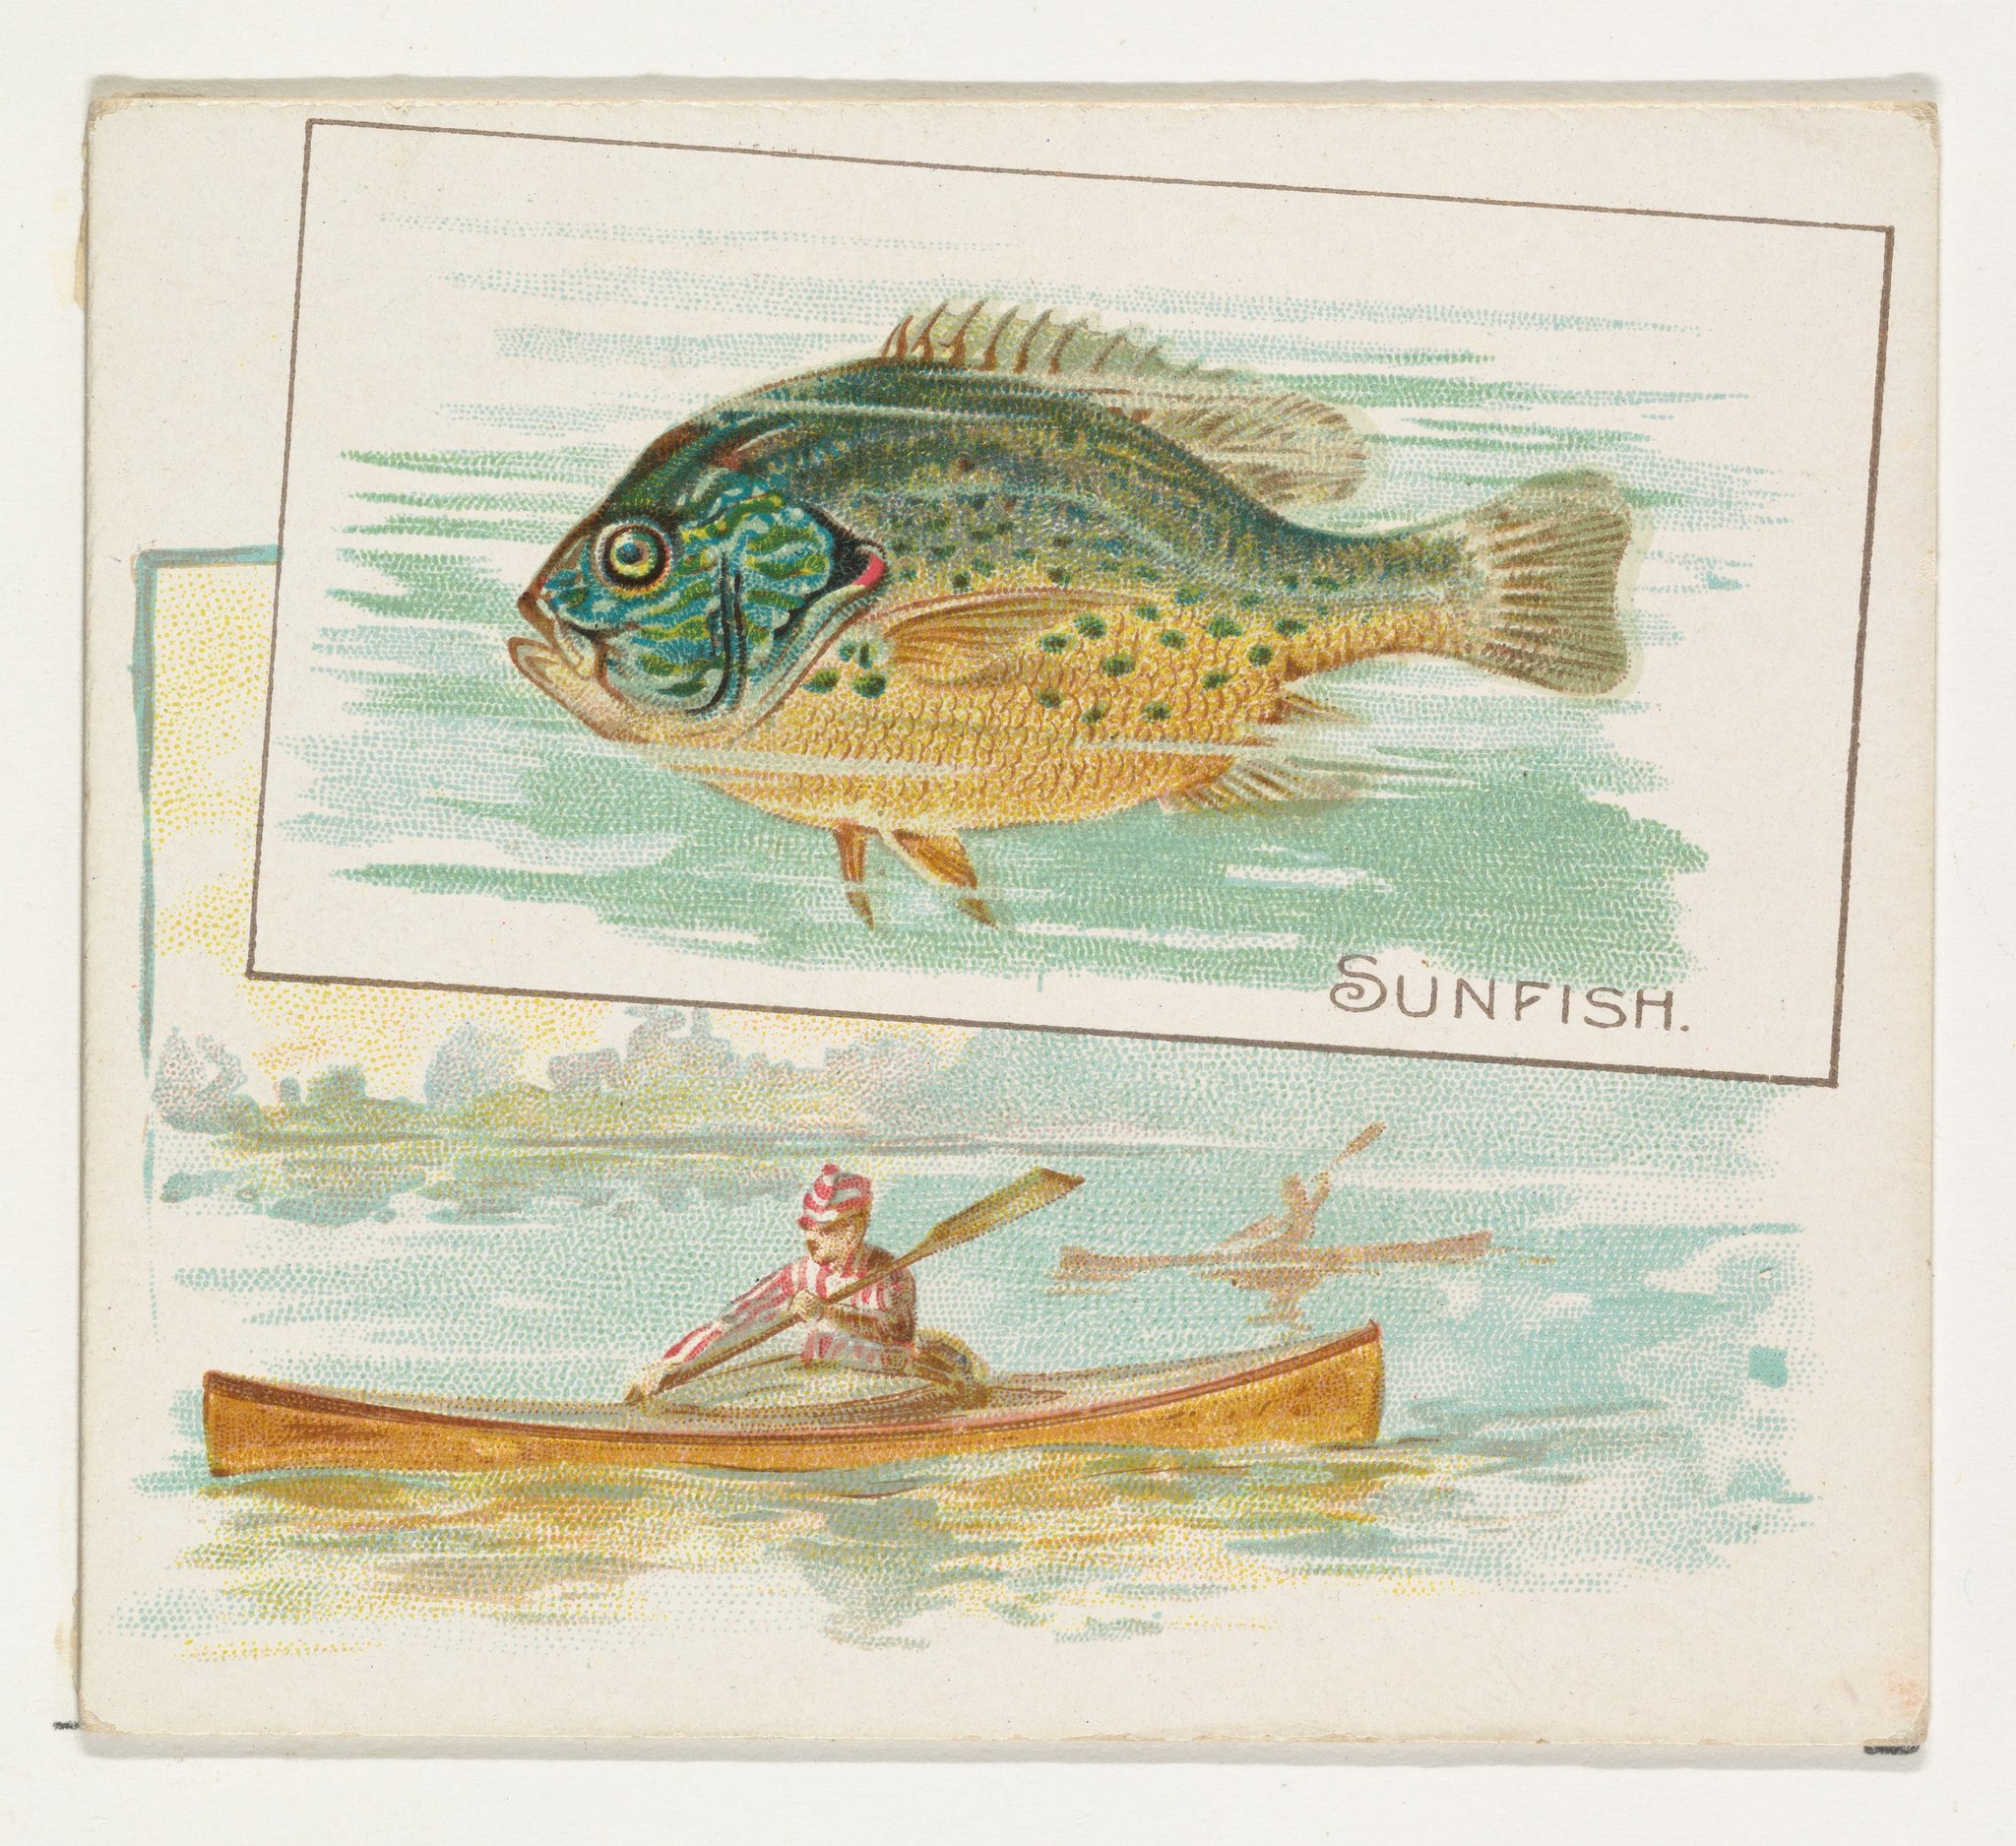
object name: print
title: Sunfish, from Fish from American Waters series (N39) for Allen & Ginter Cigarettes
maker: allen & ginter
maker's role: publisher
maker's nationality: american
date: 1889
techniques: color lithograph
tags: men,fish,boats